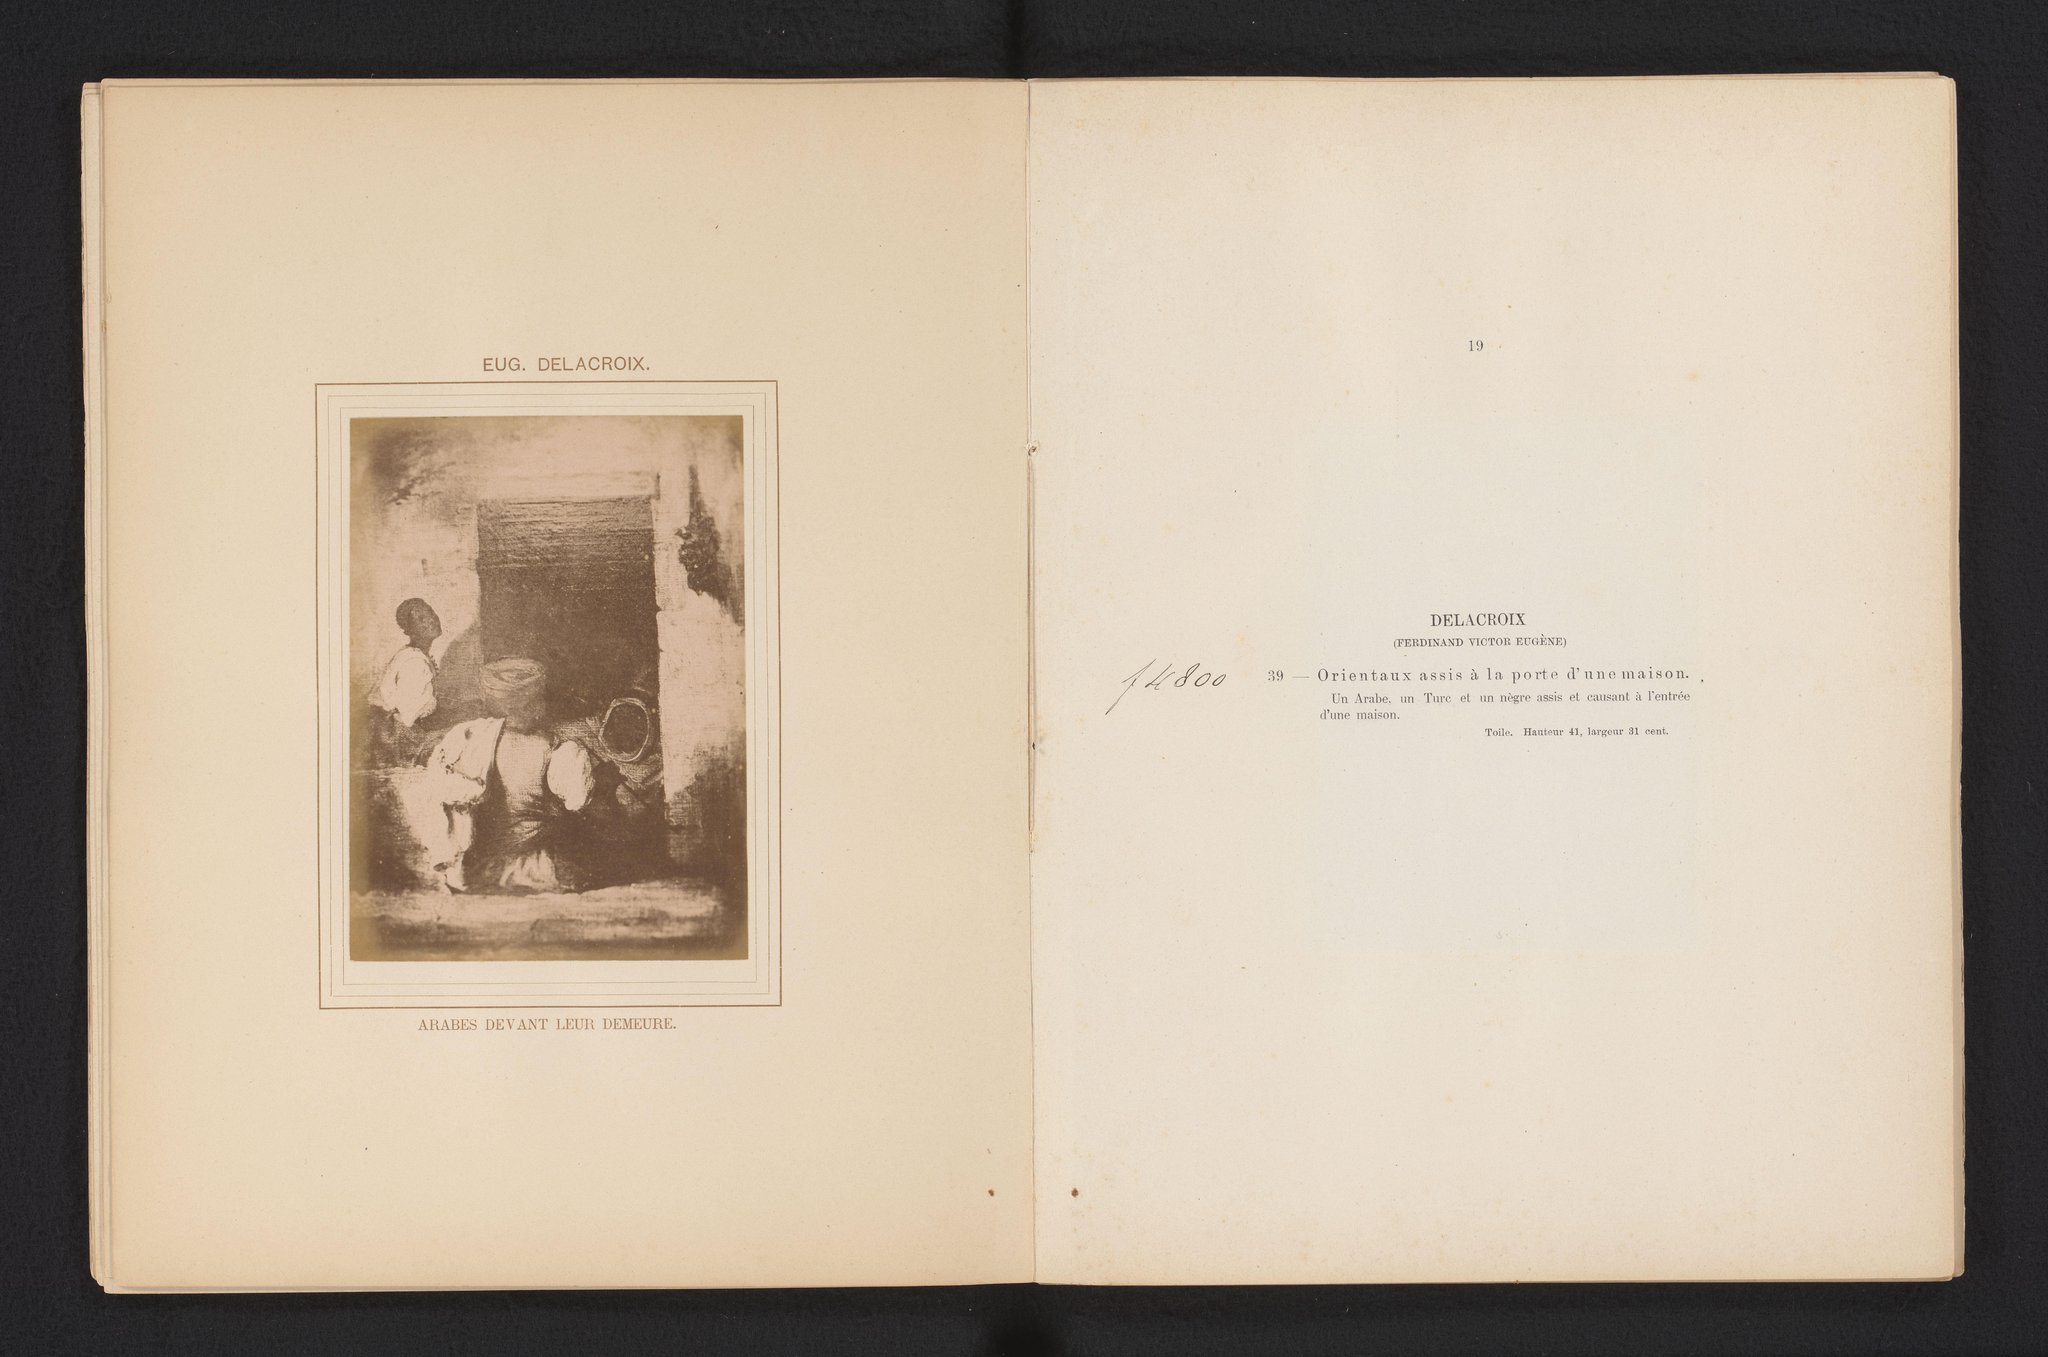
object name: page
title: Fotoreproductie van Arabes devant leur demeure door Eugène Delacroix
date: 1878-1883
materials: photographic support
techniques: albumen print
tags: open door, historical persons, painting, drawing and the graphic arts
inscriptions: inscription: ‘Eug. Delacroix’